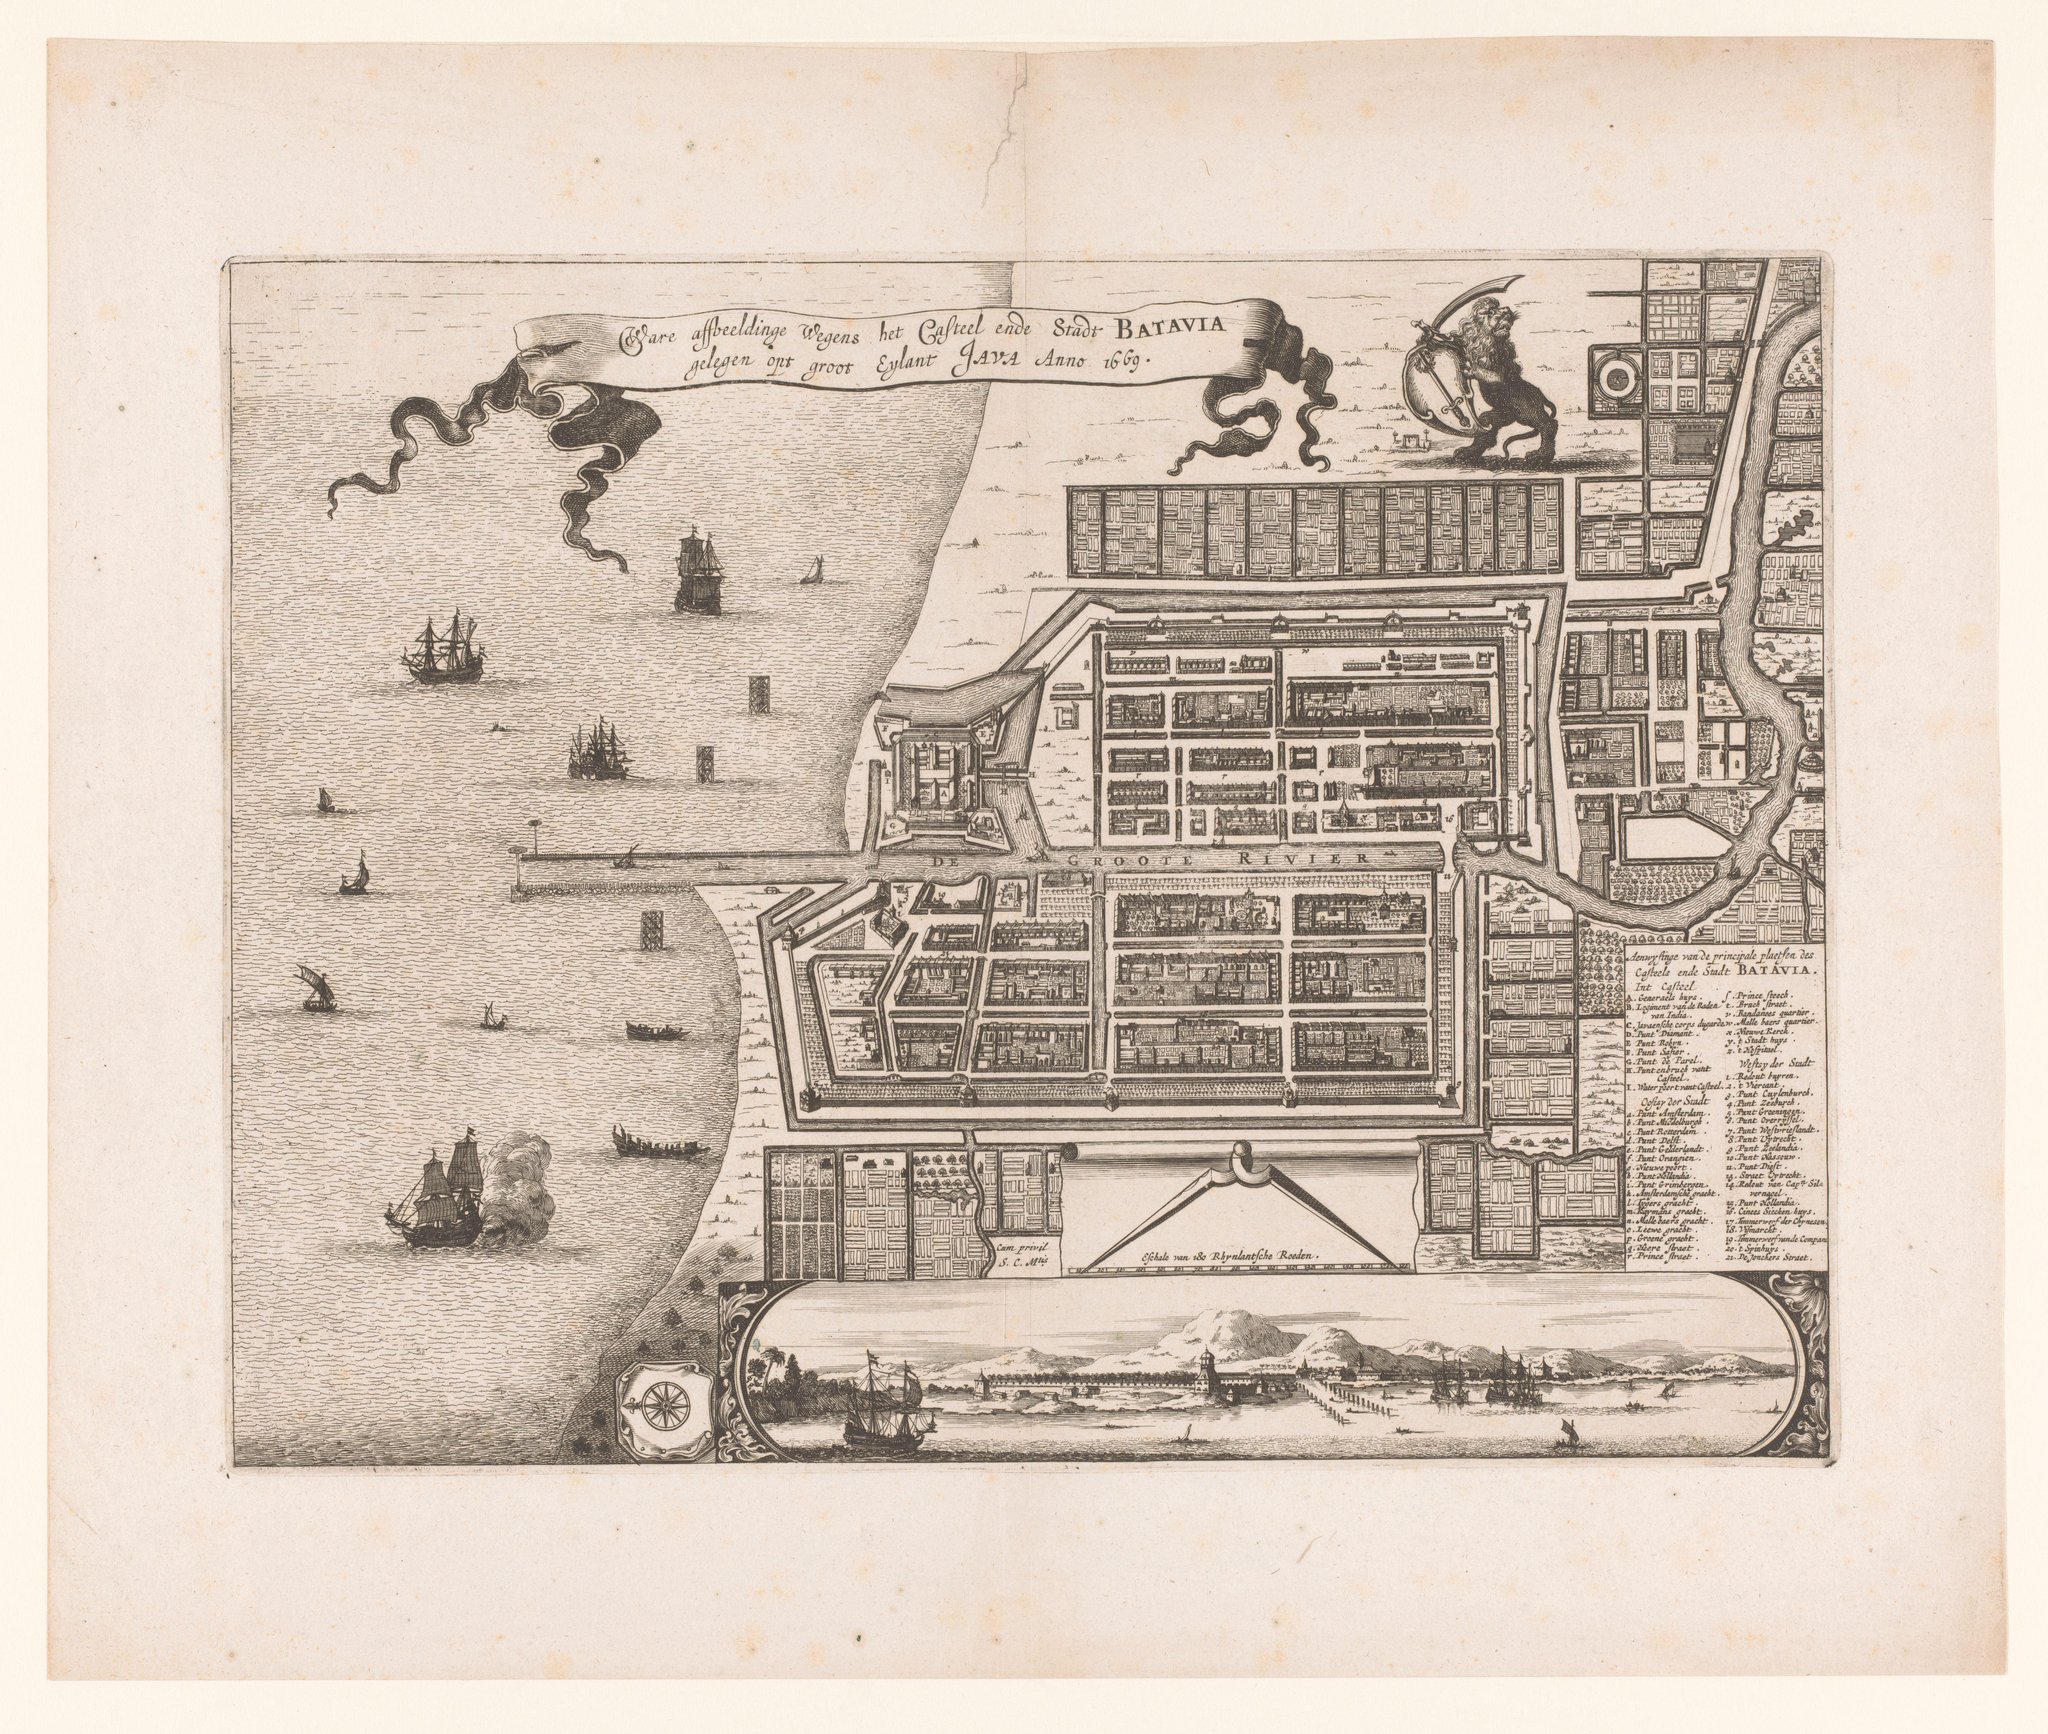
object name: area plan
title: Plattegrond van Batavia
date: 1669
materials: paper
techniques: engraving, etching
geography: amsterdam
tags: maps of cities, batavia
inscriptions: collector's mark: Lugt 2228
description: Plattegrond met titel in een banier bovenin. Daarnaast een leeuw die een schild vasthoudt met daarop het wapen van Batavia. Een legenda rechts duidt ca. 50 plaatsen op de kaart. Onderin een schaalstok in Rijnlandse roeden en daaronder een klein gezicht op de stad vanaf zee.